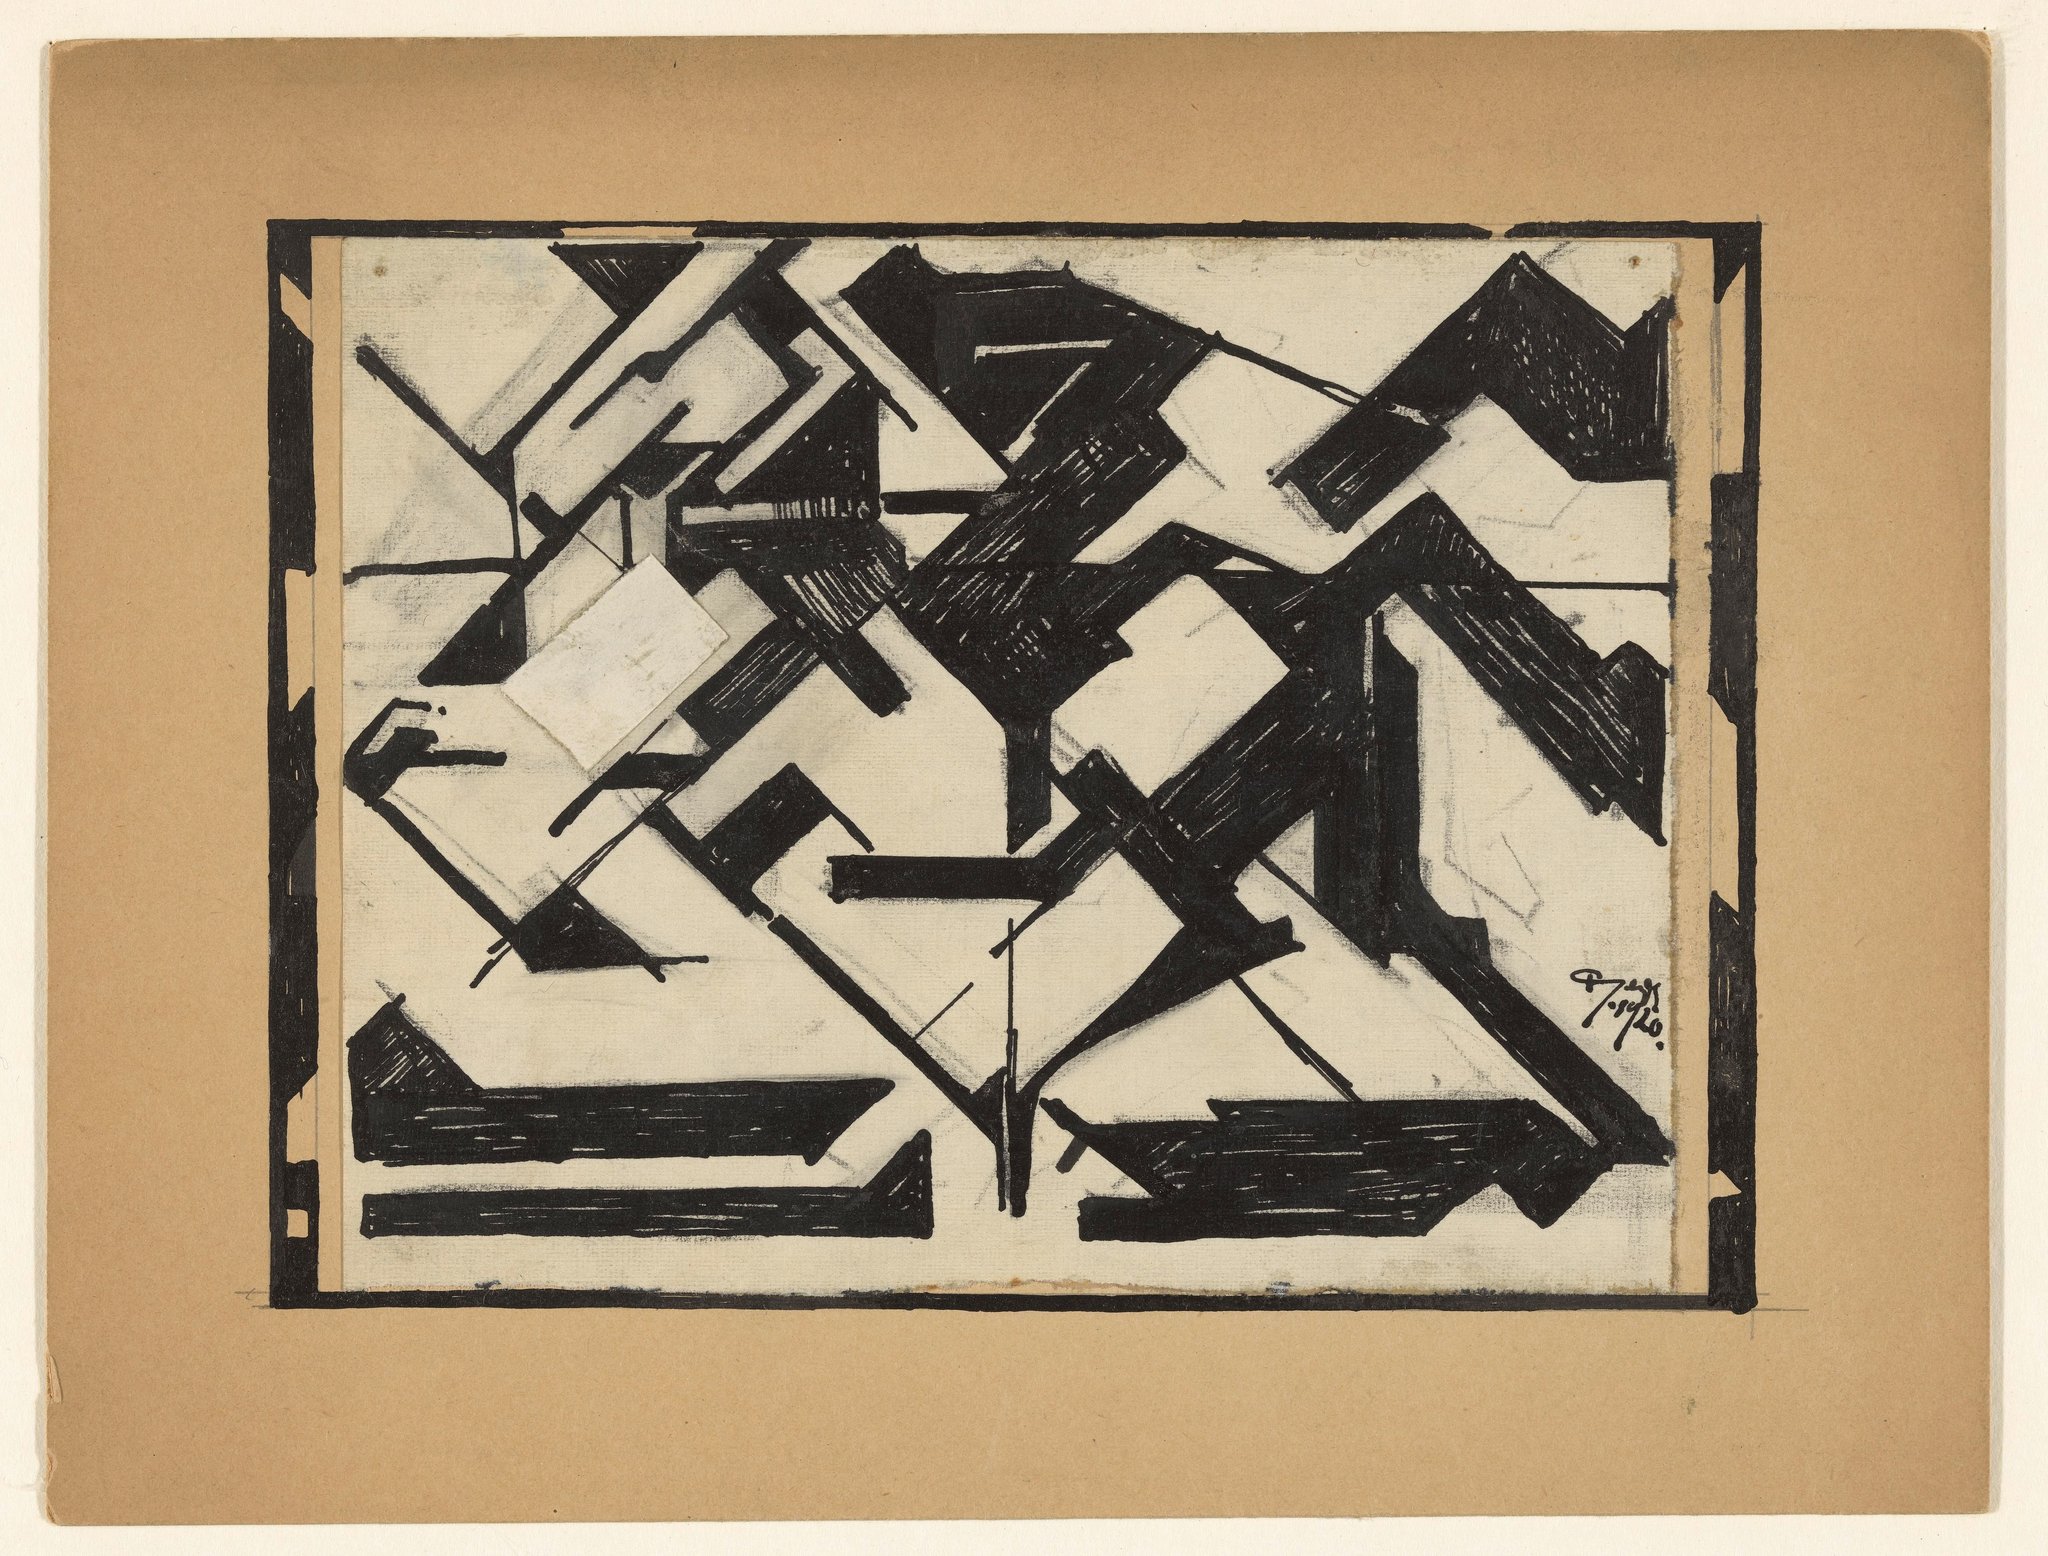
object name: drawing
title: Ruiter te paard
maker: reijer stolk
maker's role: draughtsman, print maker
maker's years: 1896-1945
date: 1920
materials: cardboard, ink, paper, pencil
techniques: pen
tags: riding a horse, ass, or mule; rider, horseman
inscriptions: collector's mark: Lugt 2228, collector's mark: Lugt 2760